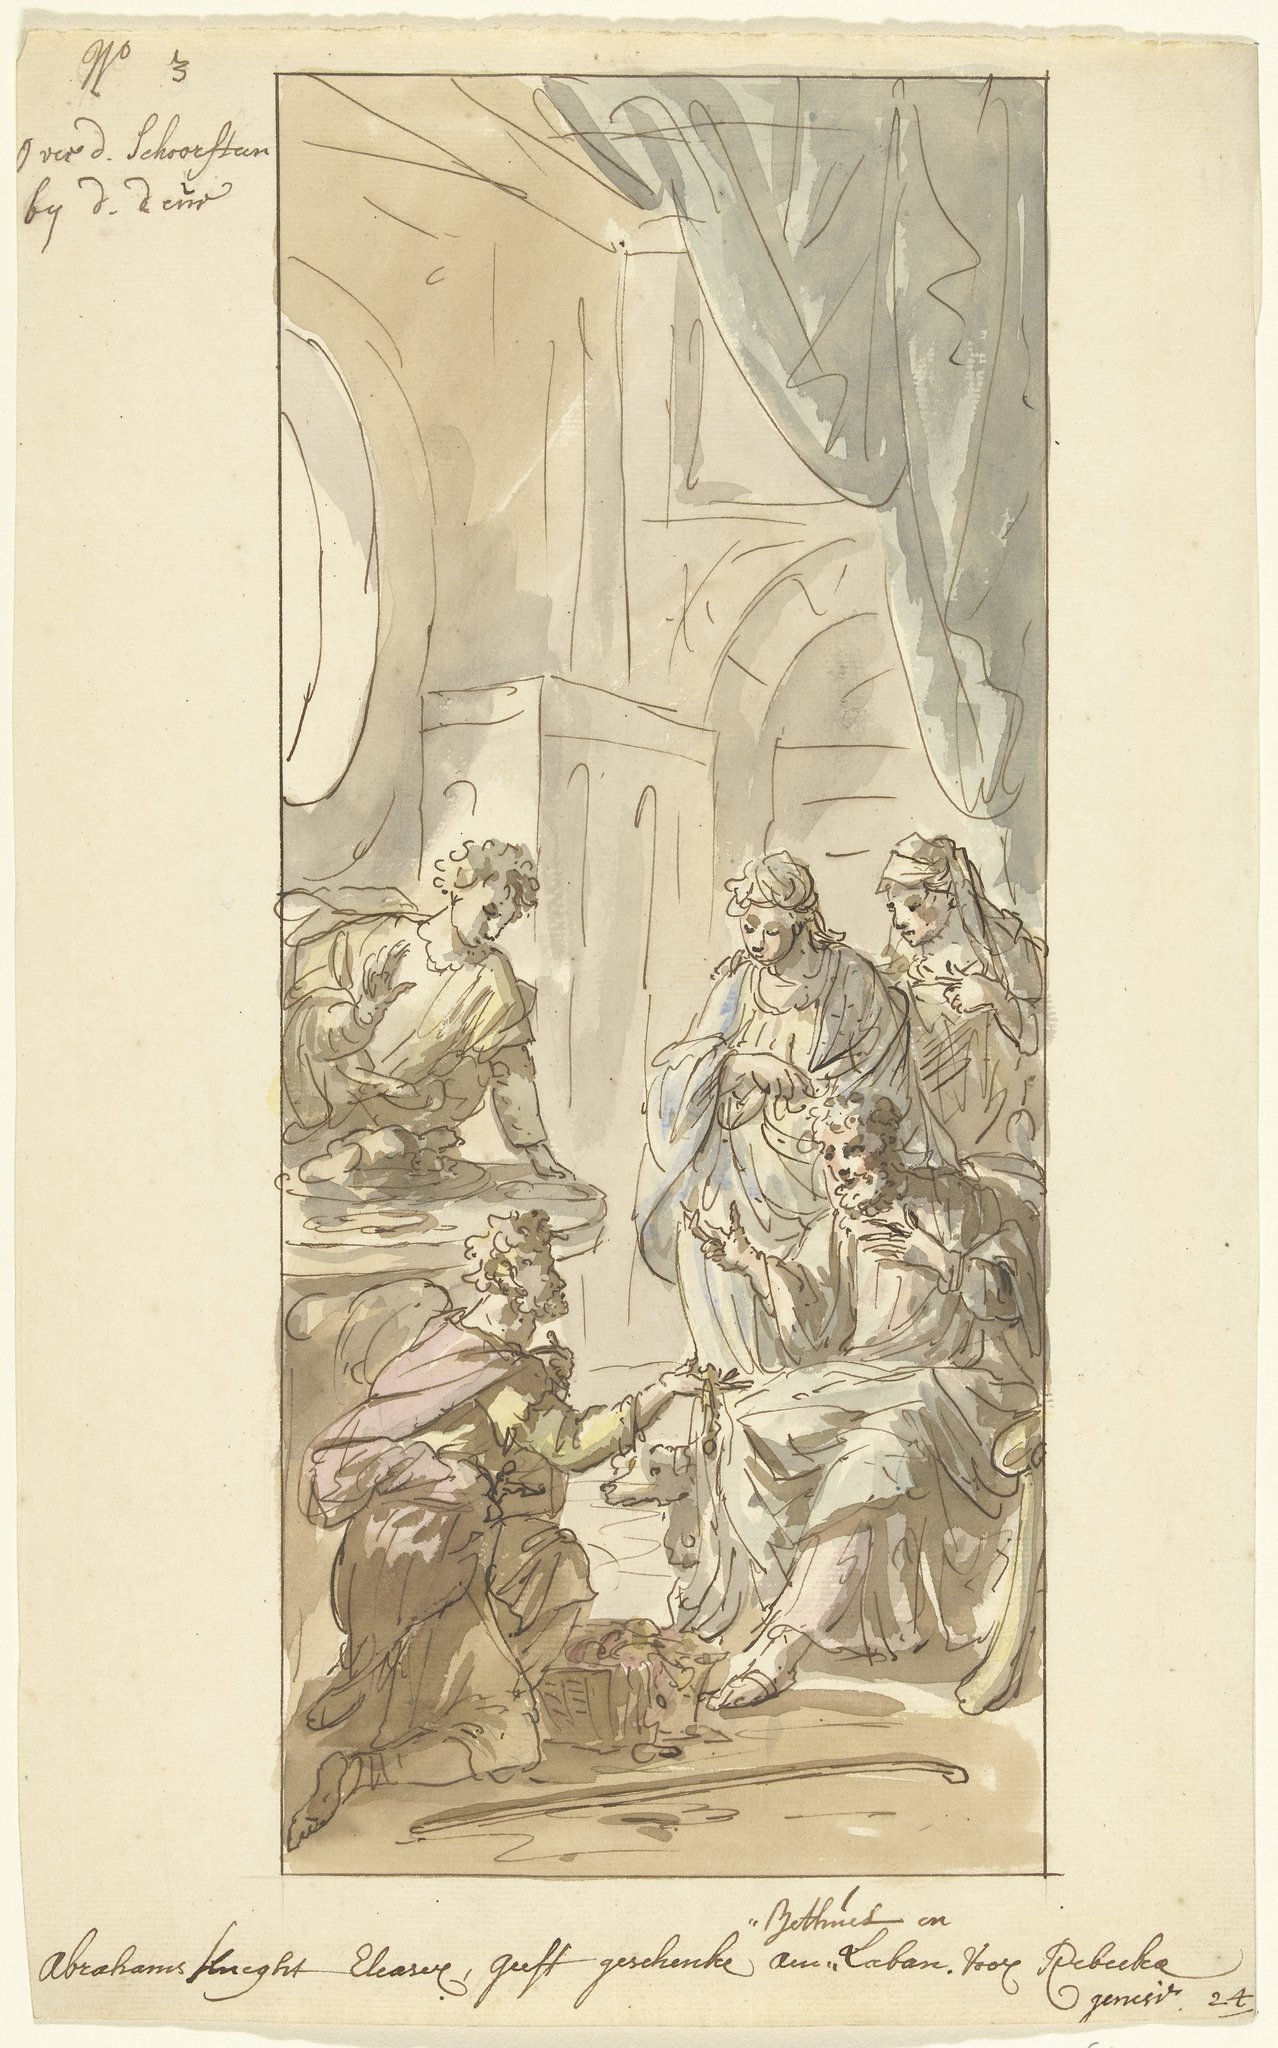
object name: drawing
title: Eliëzer geeft geschenken aan Rebekka, haar moeder en haar broer Laban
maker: elias van nijmegen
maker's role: draughtsman, painter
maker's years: 1667-1755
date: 1677-1755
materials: ink, paper, watercolor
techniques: brush, pen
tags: gifts of clothing, gold and jewellery are offered to rebekah's parents